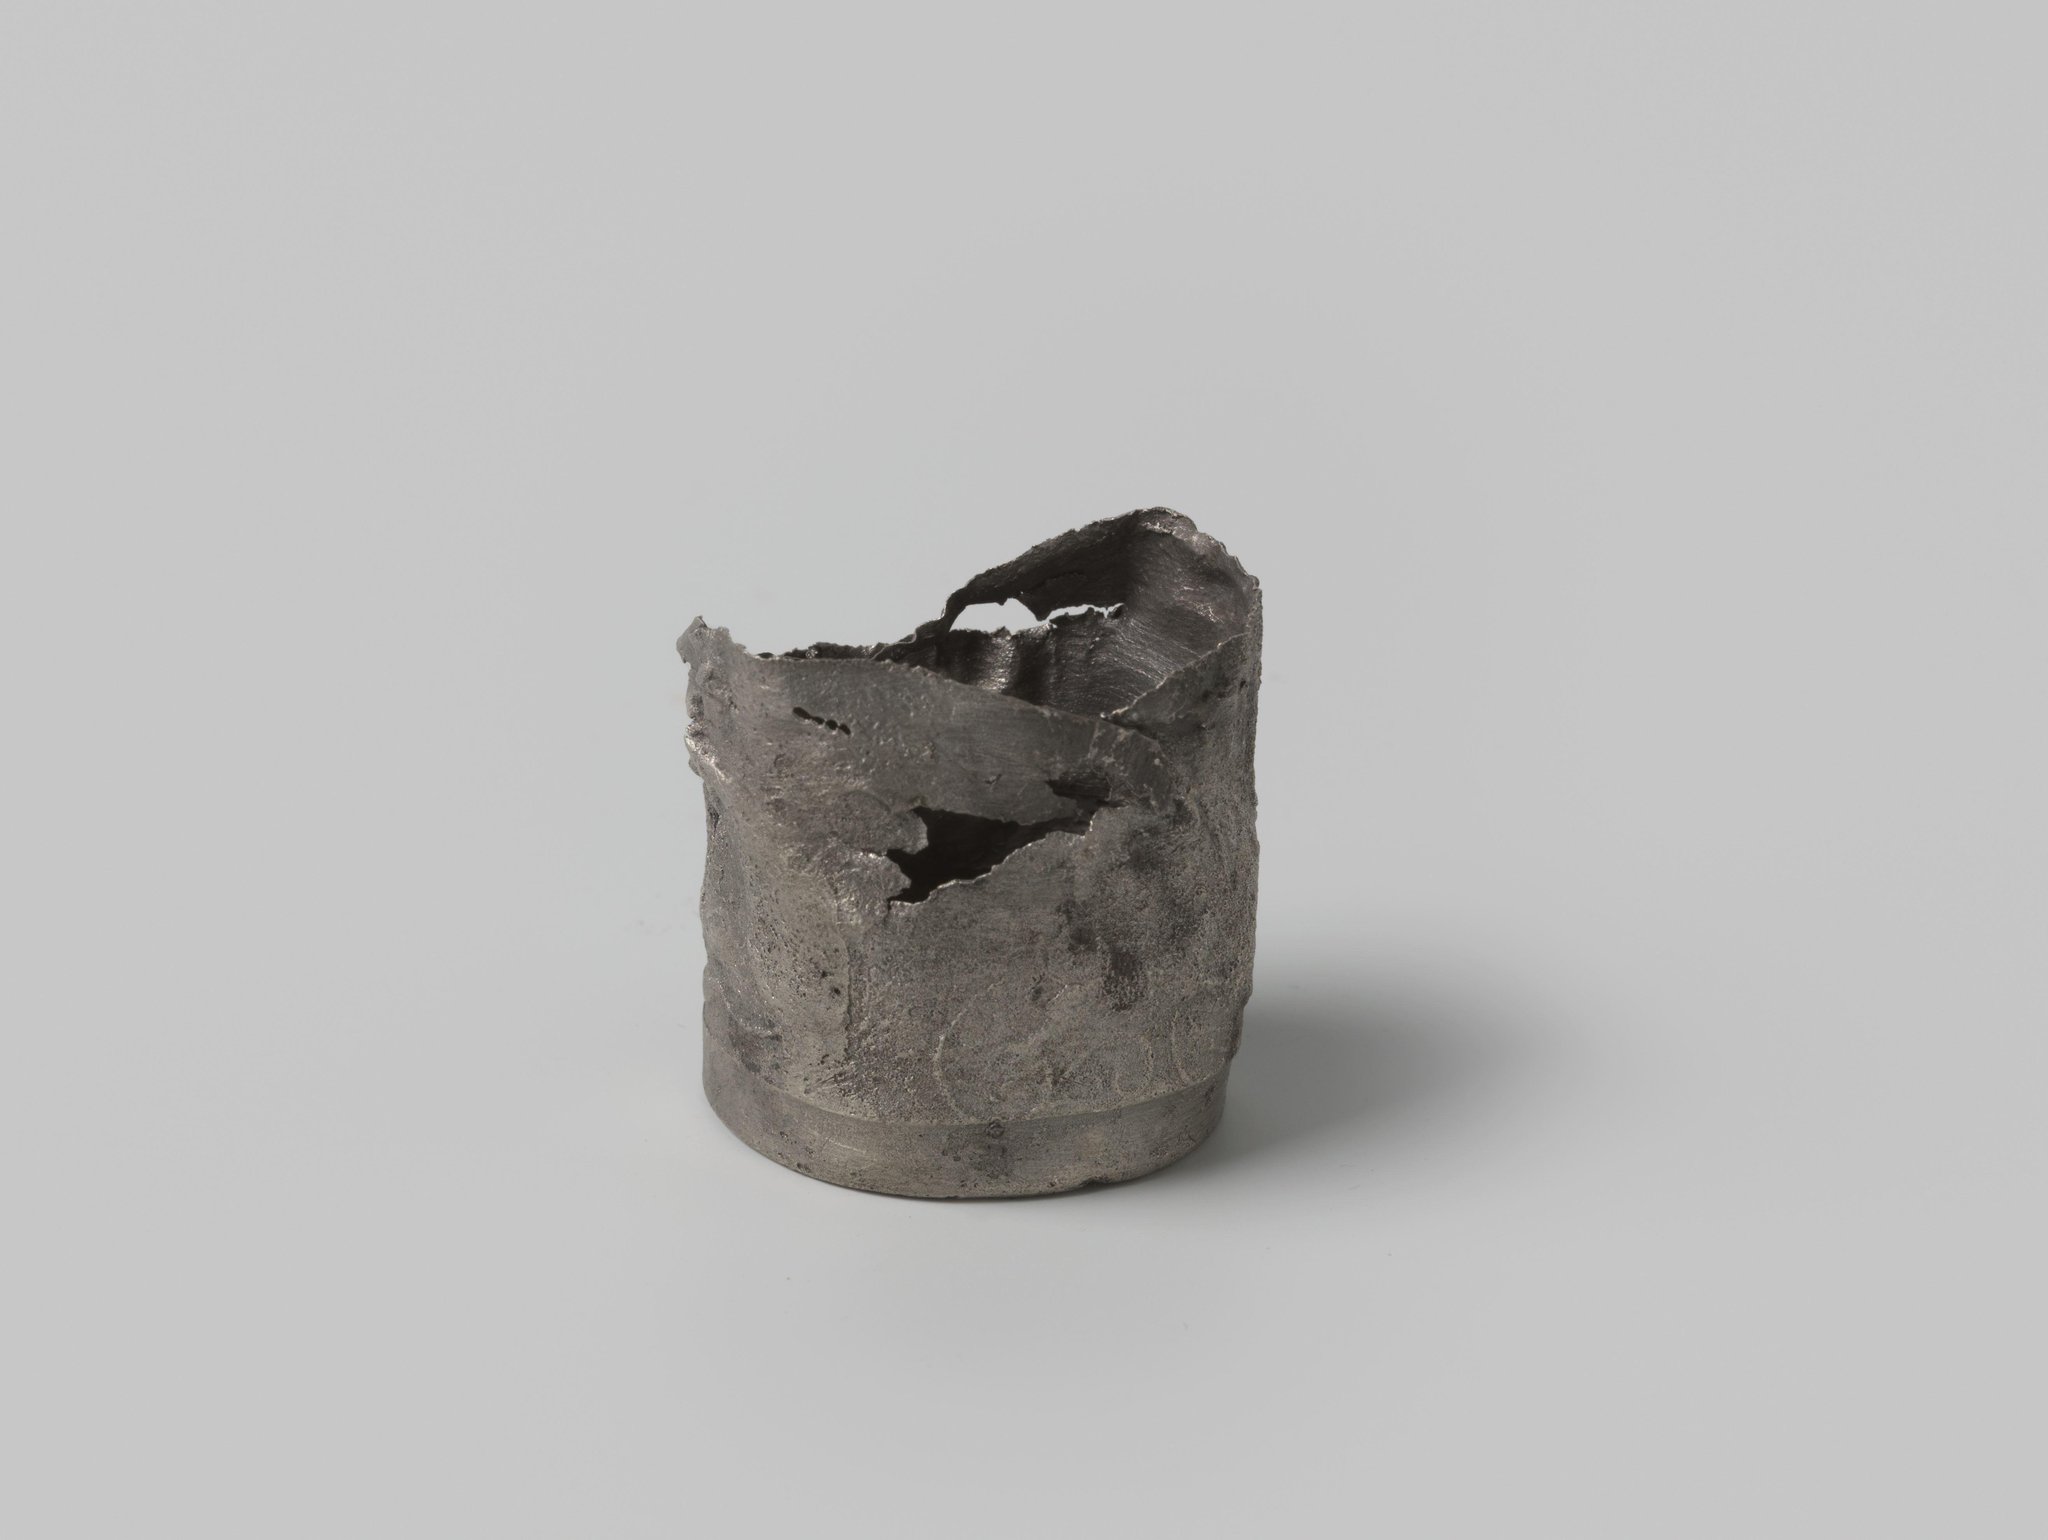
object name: cup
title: Beker uit het wrak van de Oost-Indiëvaarder Hollandia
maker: Anonymous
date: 1700-1743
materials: tin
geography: netherlands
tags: verenigde oostindische compagnie, hollandia (schip), annet